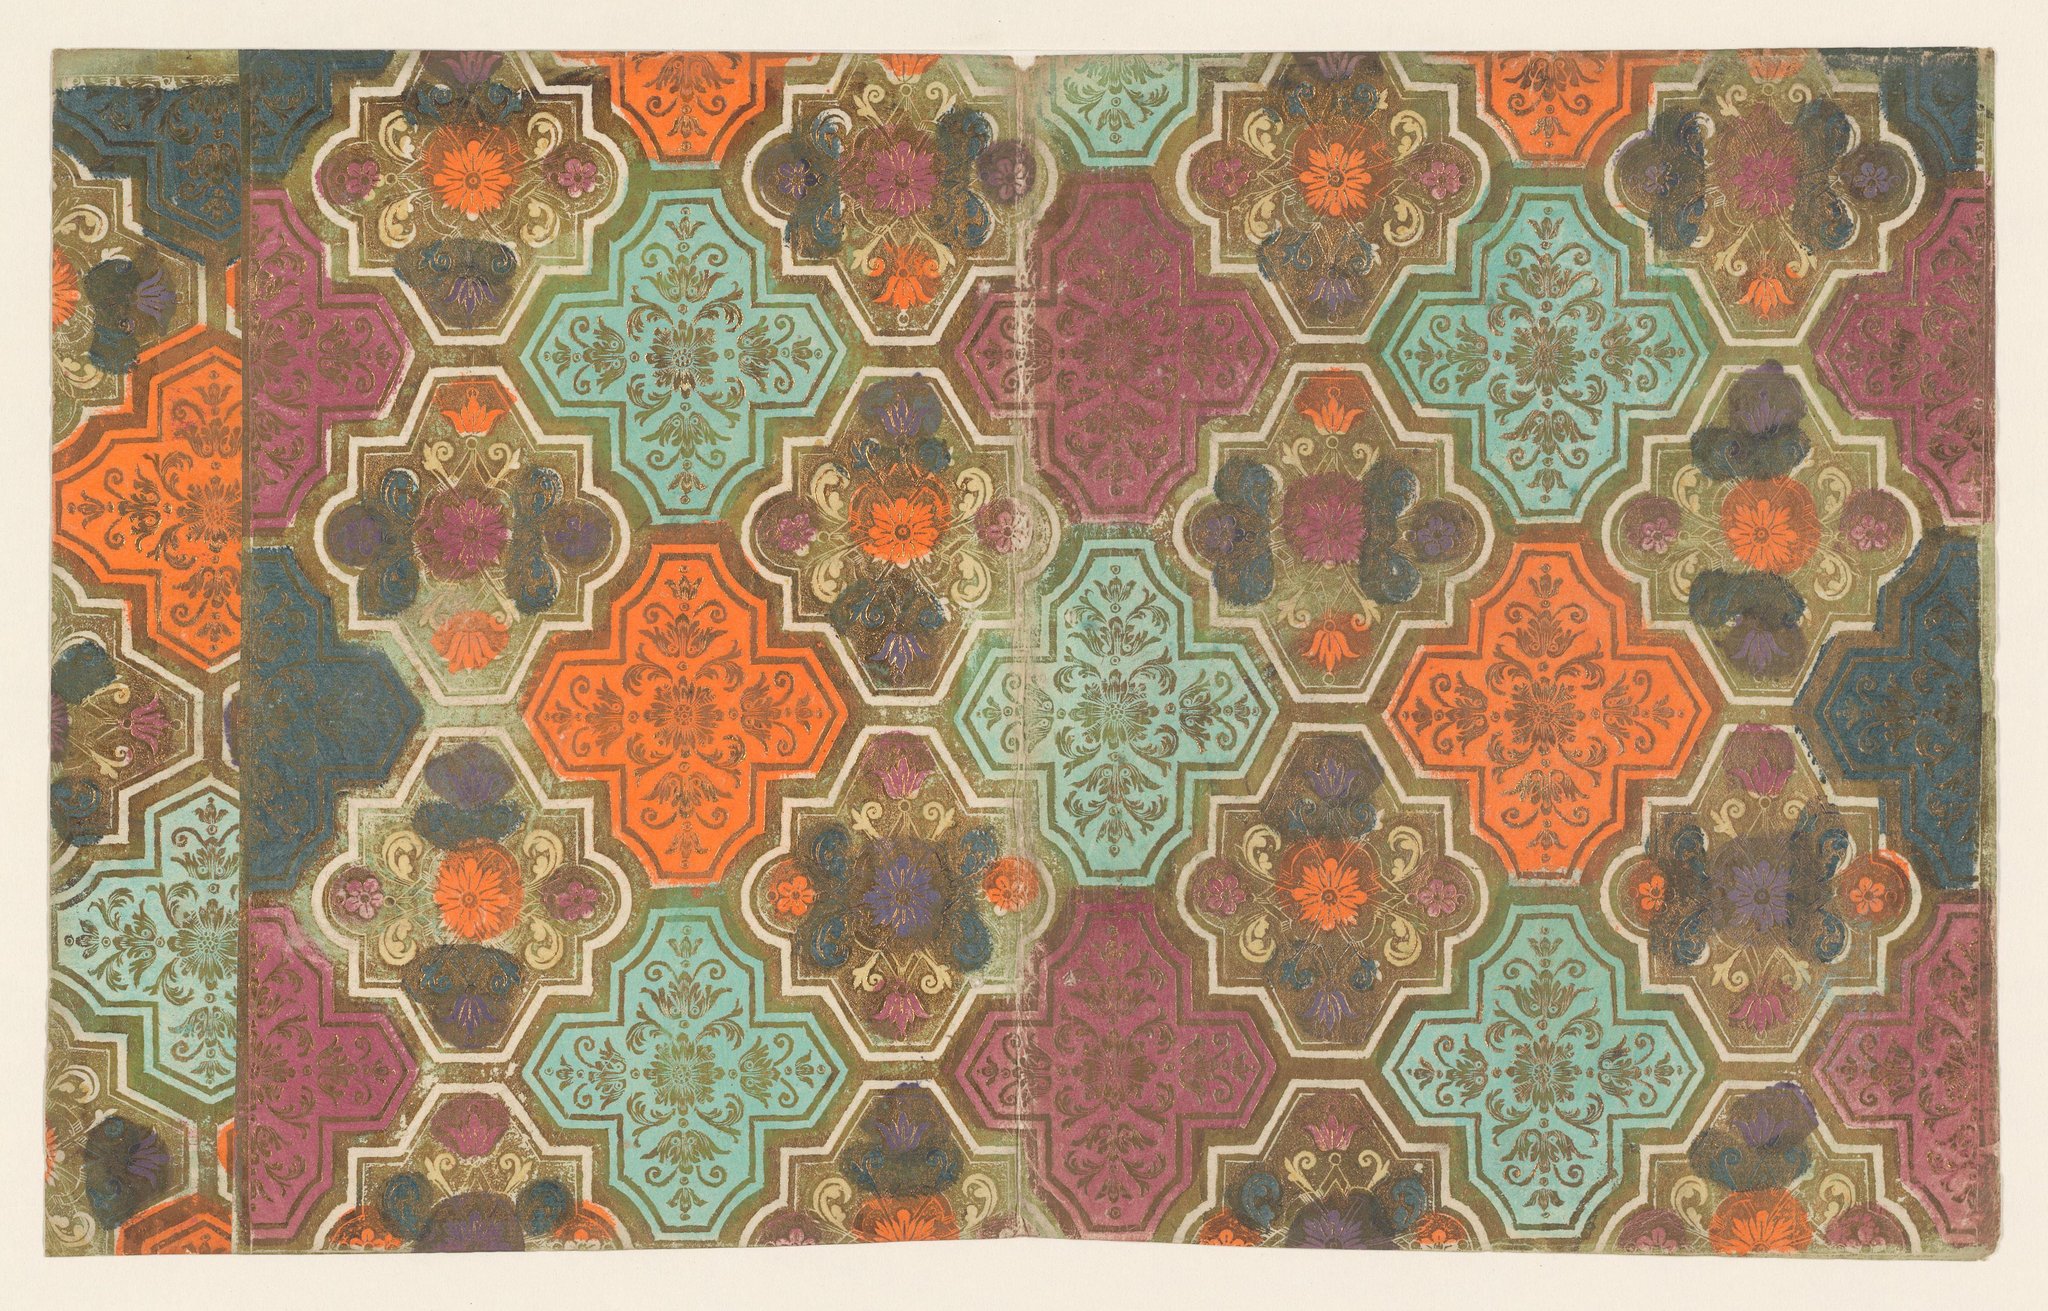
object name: brocade paper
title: Blad met alternerend tegelpatroon van ornamenten met bloemmotieven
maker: Anonymous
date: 1700-1850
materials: gold leaf, paint, paper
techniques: relief print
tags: ornament derived from plant forms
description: Blad met alternerend tegelpatroon van ornamenten met bloemmotieven. Gebruikt als omslag.